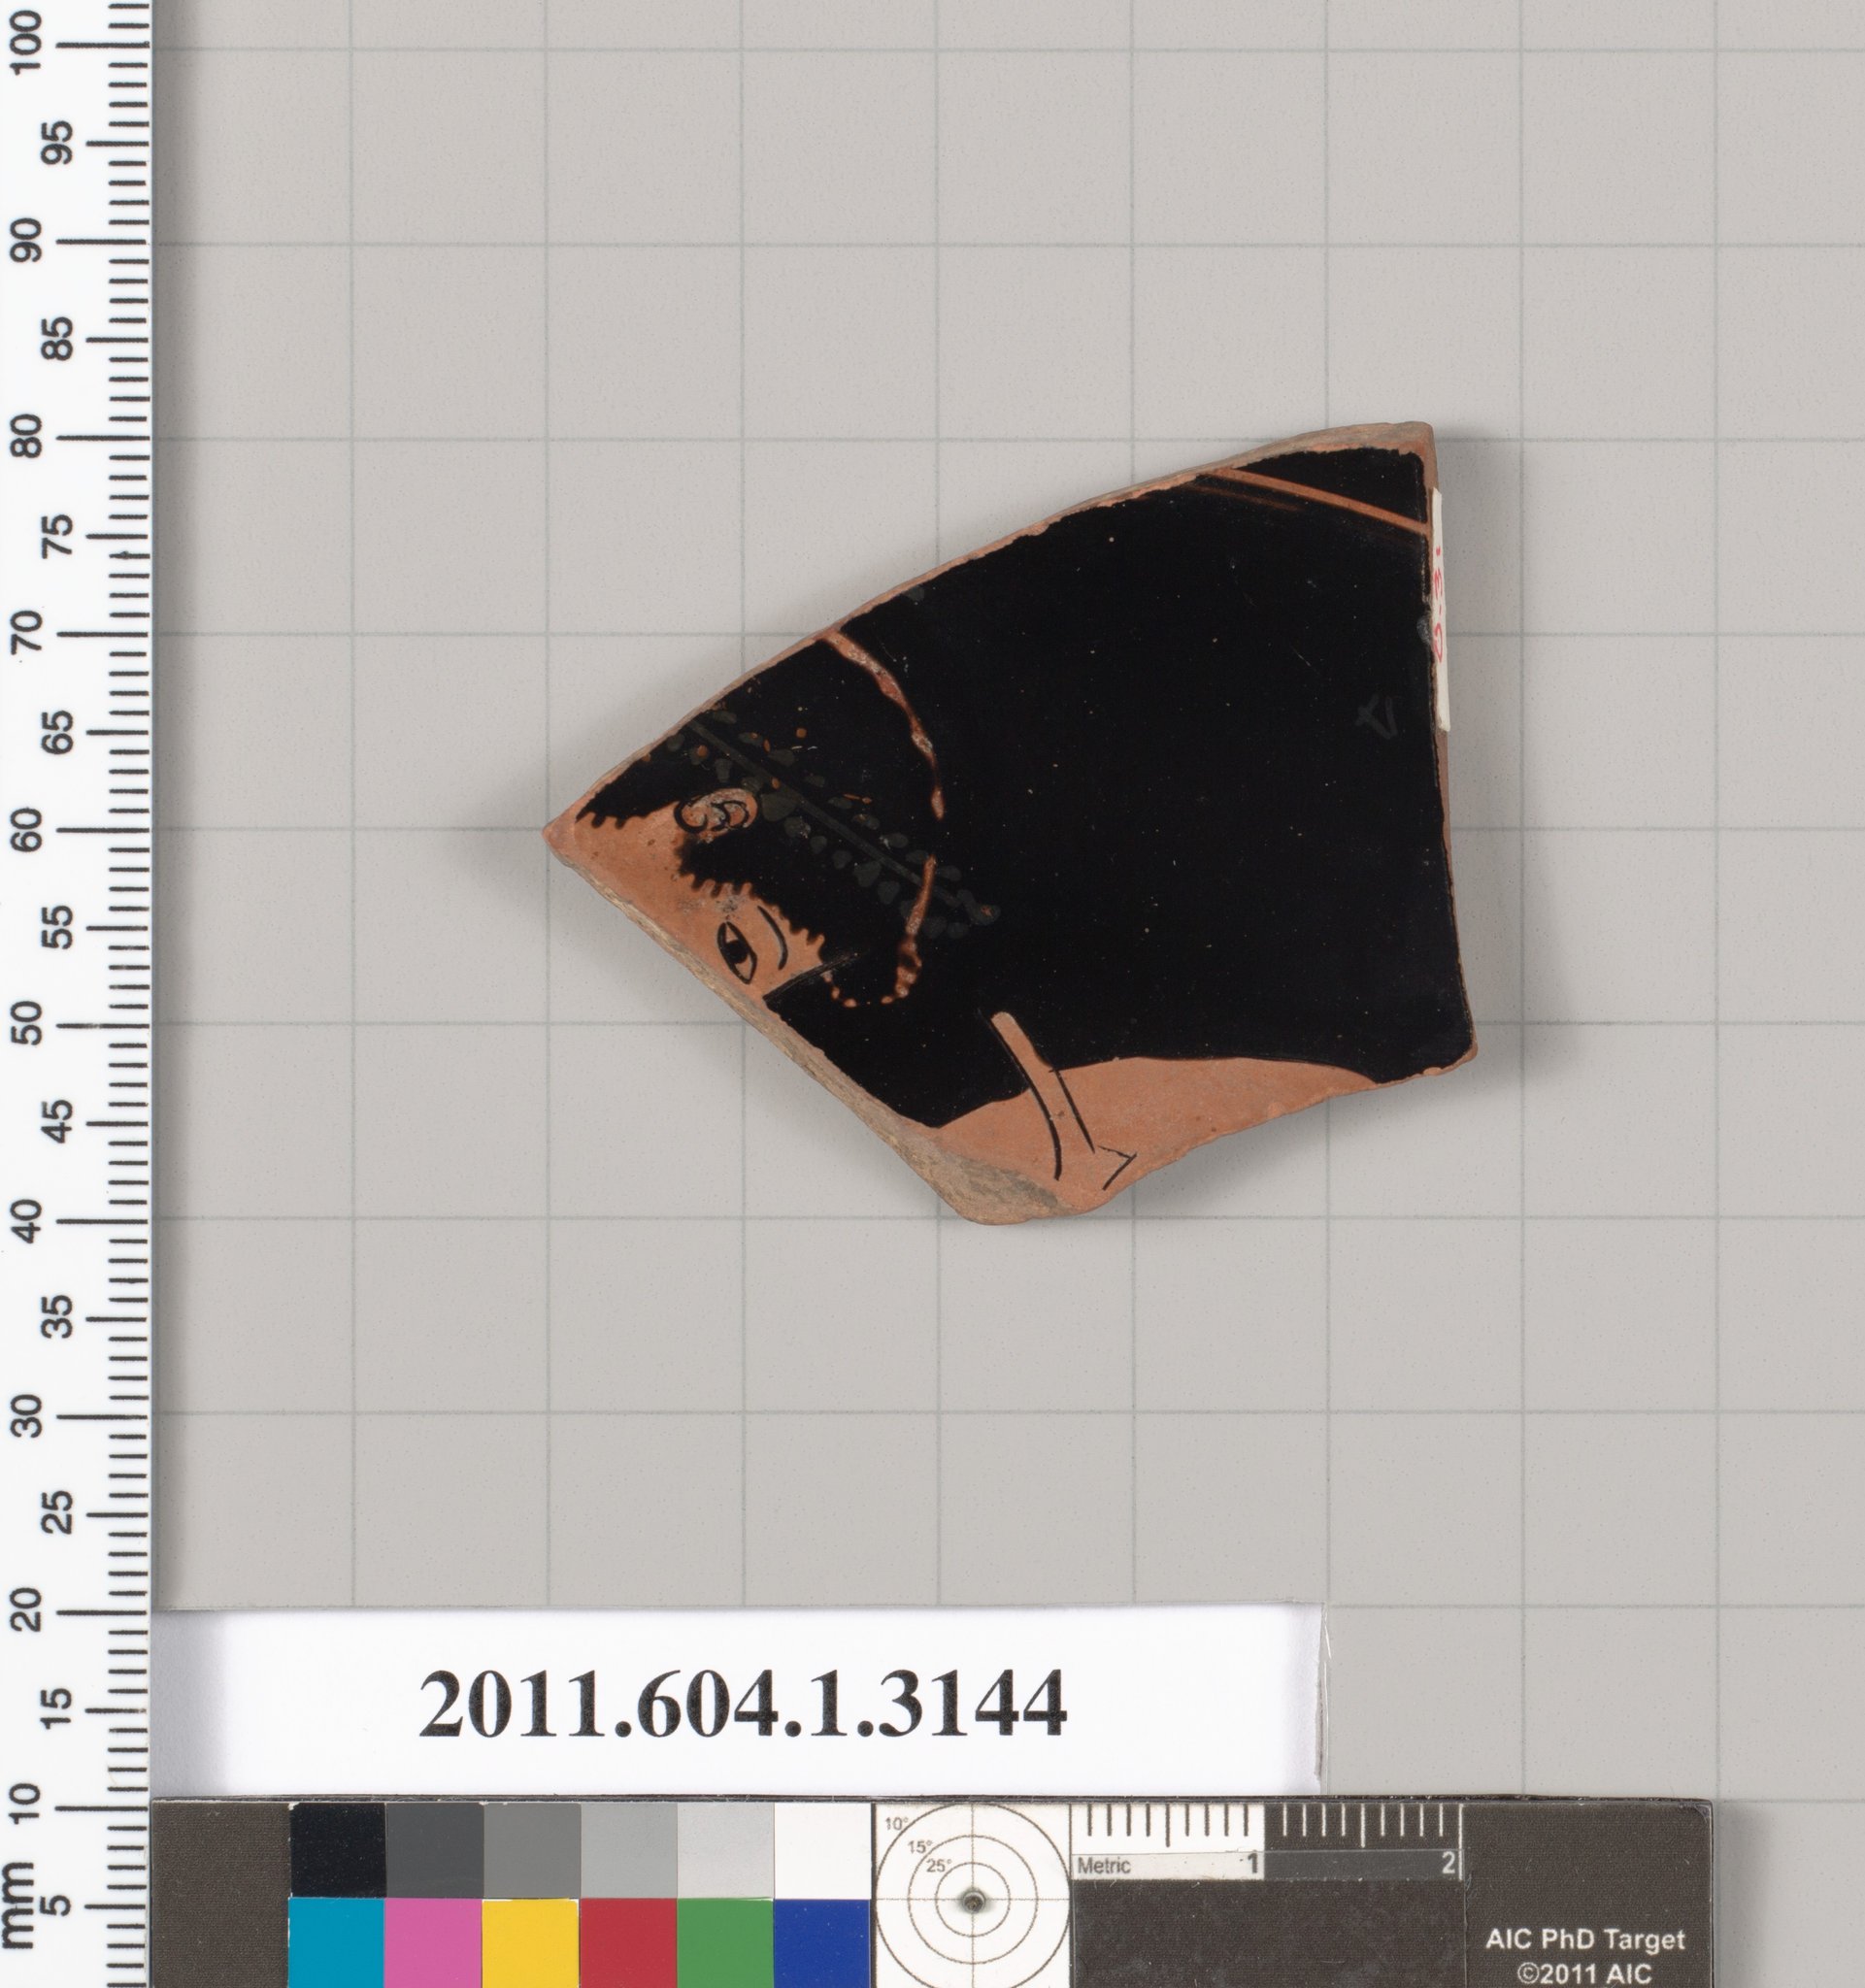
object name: kylix fragment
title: Terracotta fragment of a kylix (drinking cup)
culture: greek, attic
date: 510-490 BCE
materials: terracotta